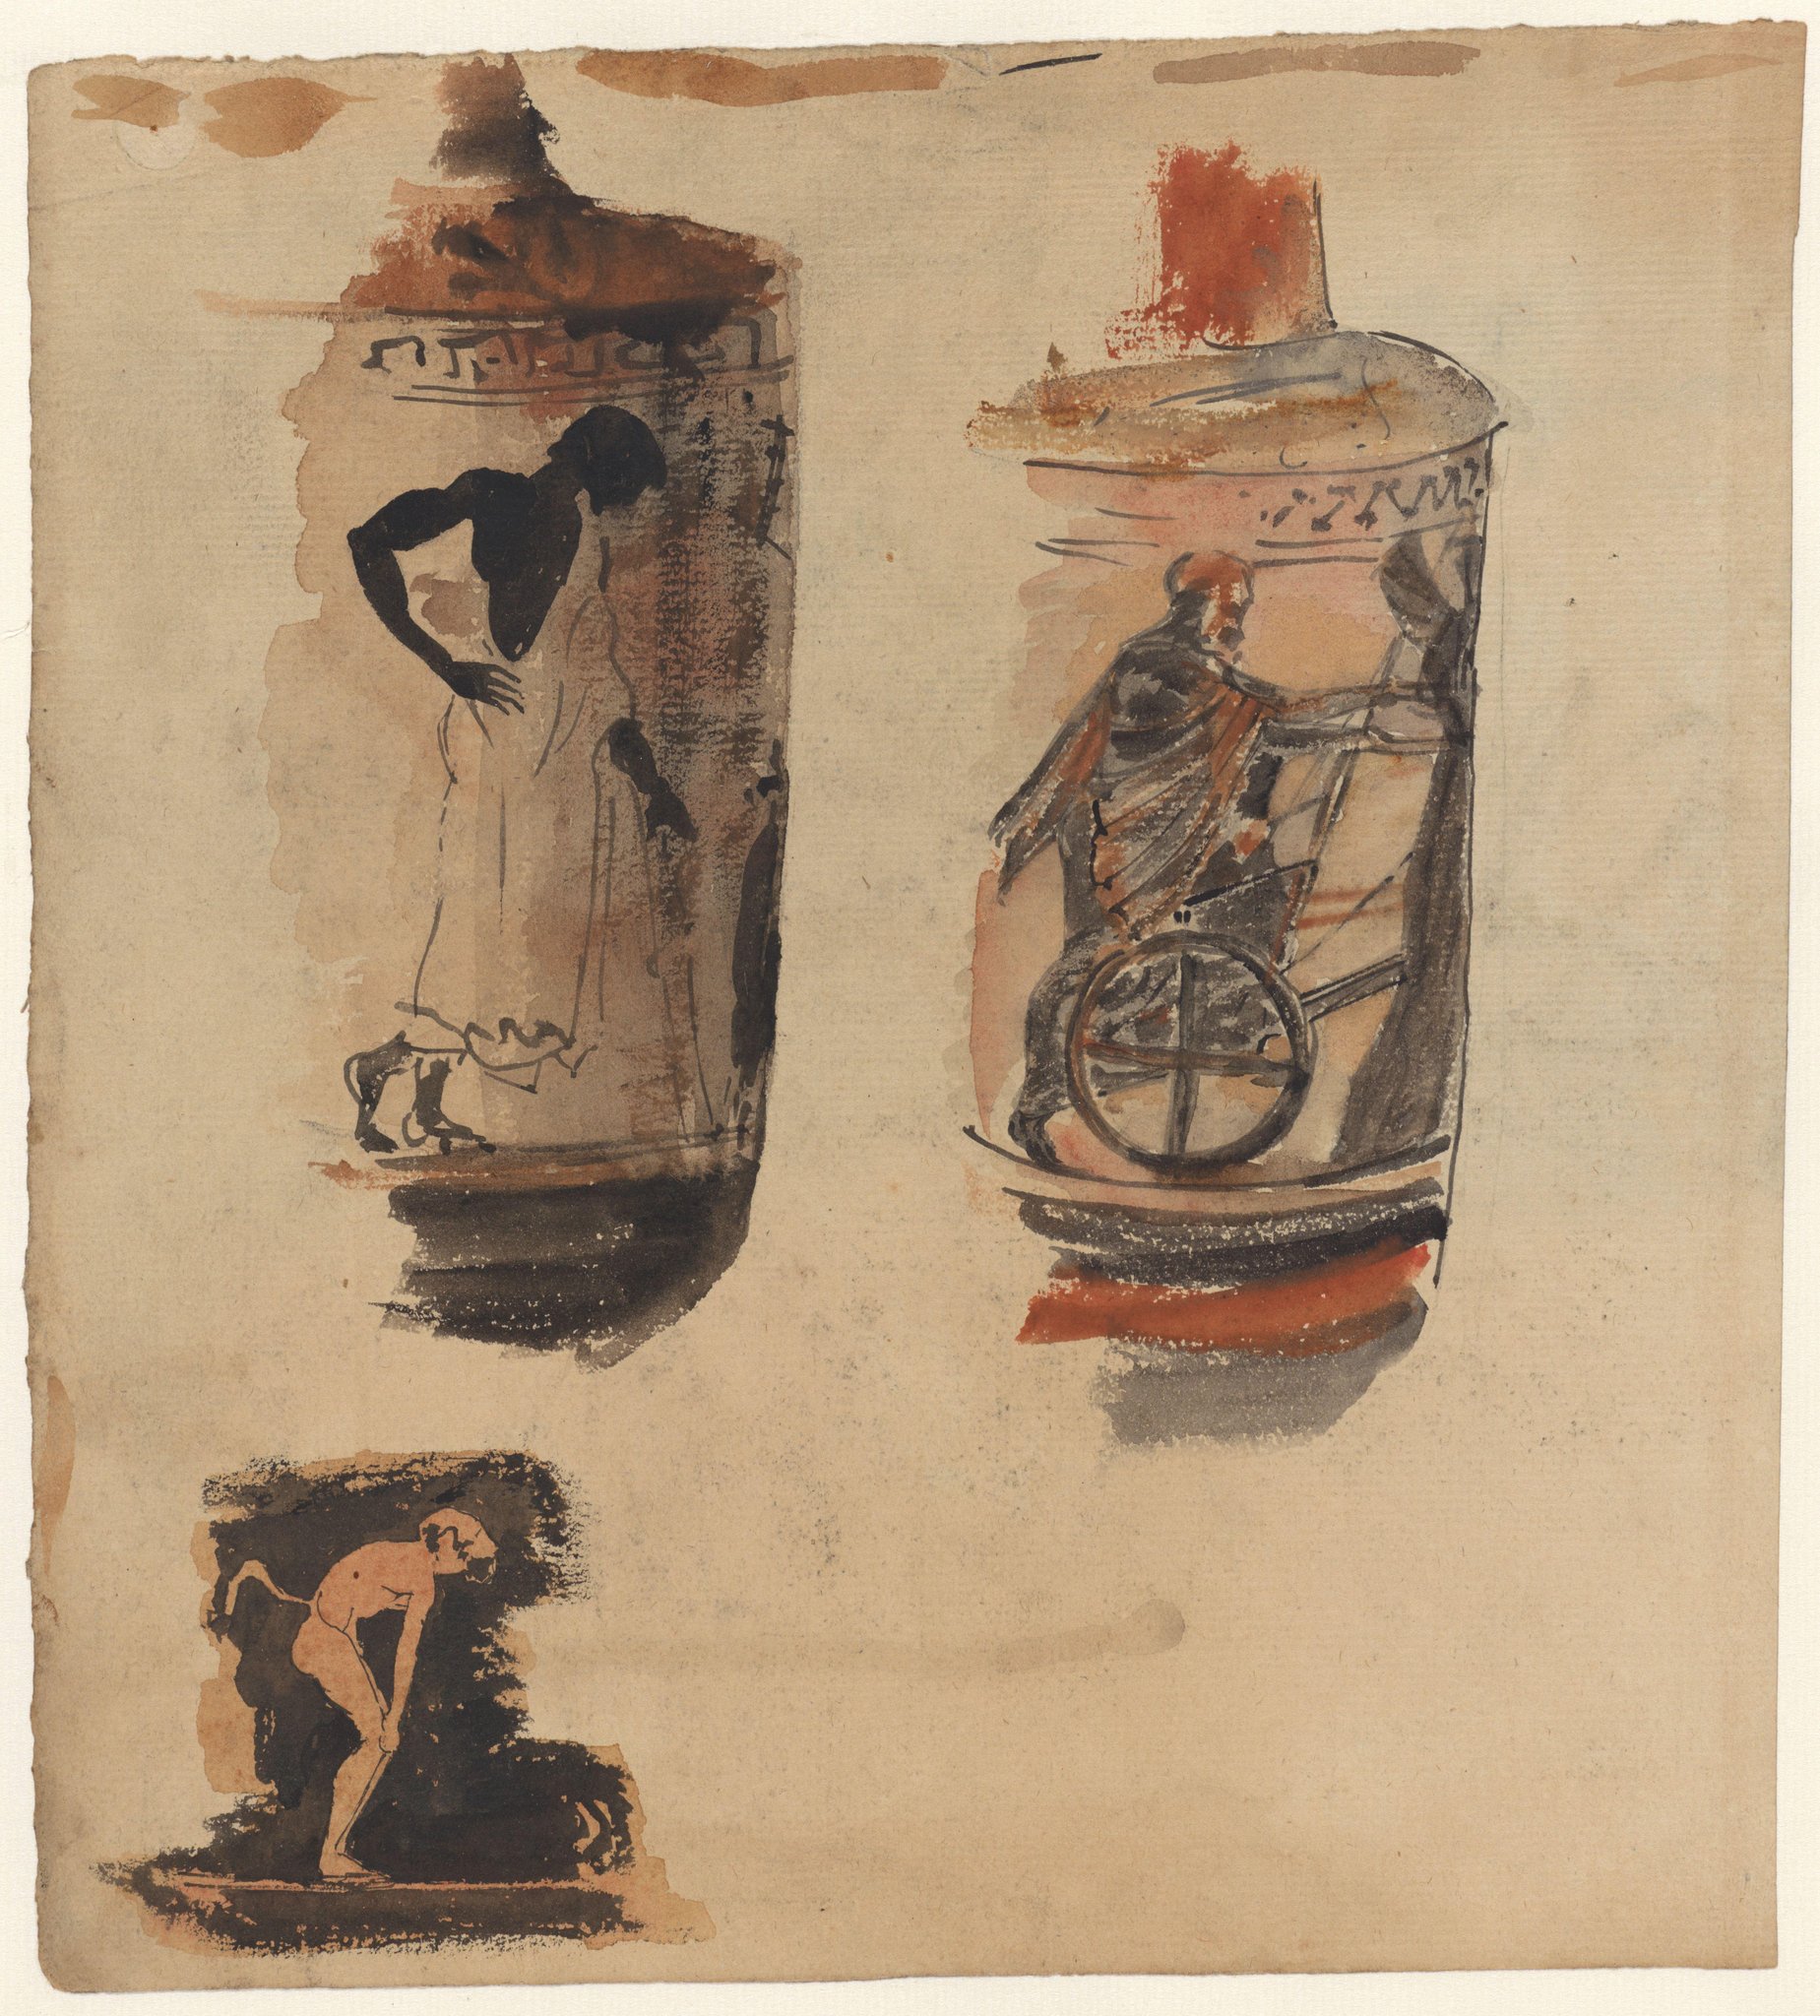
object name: drawing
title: Details van Griekse vazen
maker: theo nieuwenhuis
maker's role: designer, draughtsman, print maker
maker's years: 1866-1951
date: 1876-1951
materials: ink, paper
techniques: brush, pen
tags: container of ceramics: jar, jug, pot, vase, work of applied art (+ greek art)